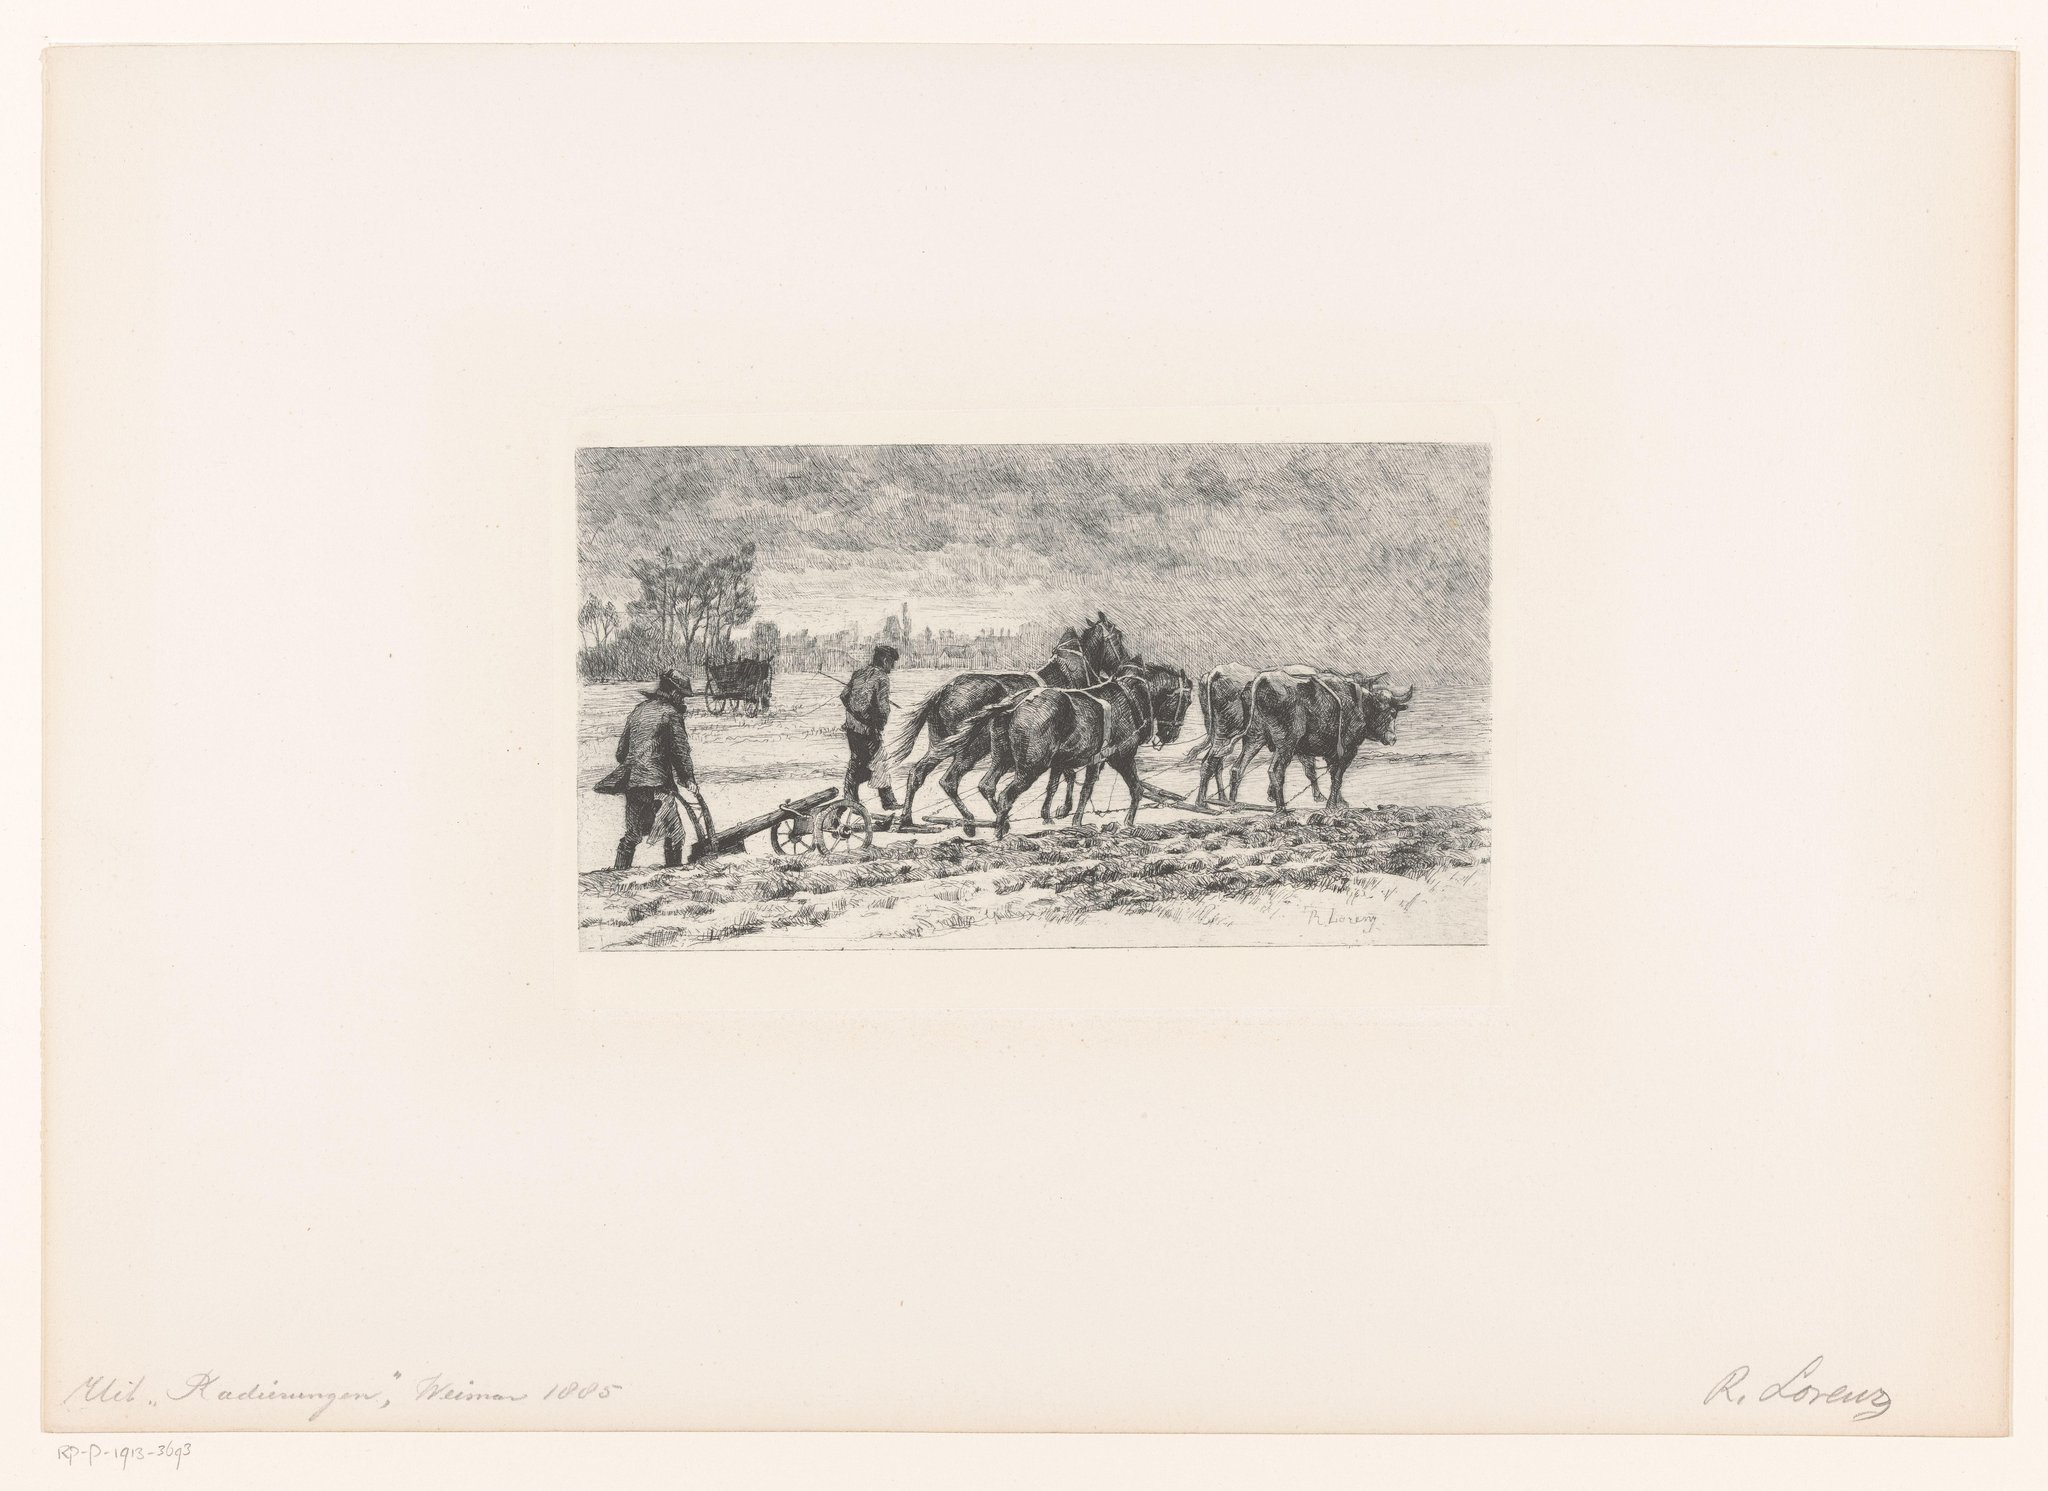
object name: print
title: Schwerer Boden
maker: richard lorenz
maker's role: print maker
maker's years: 1858-1915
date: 1885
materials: paper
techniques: etching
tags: ploughing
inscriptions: : ‘Uit "Radierungen", Weimar 1885 R. Lorenz’, collector's mark: Lugt 2228